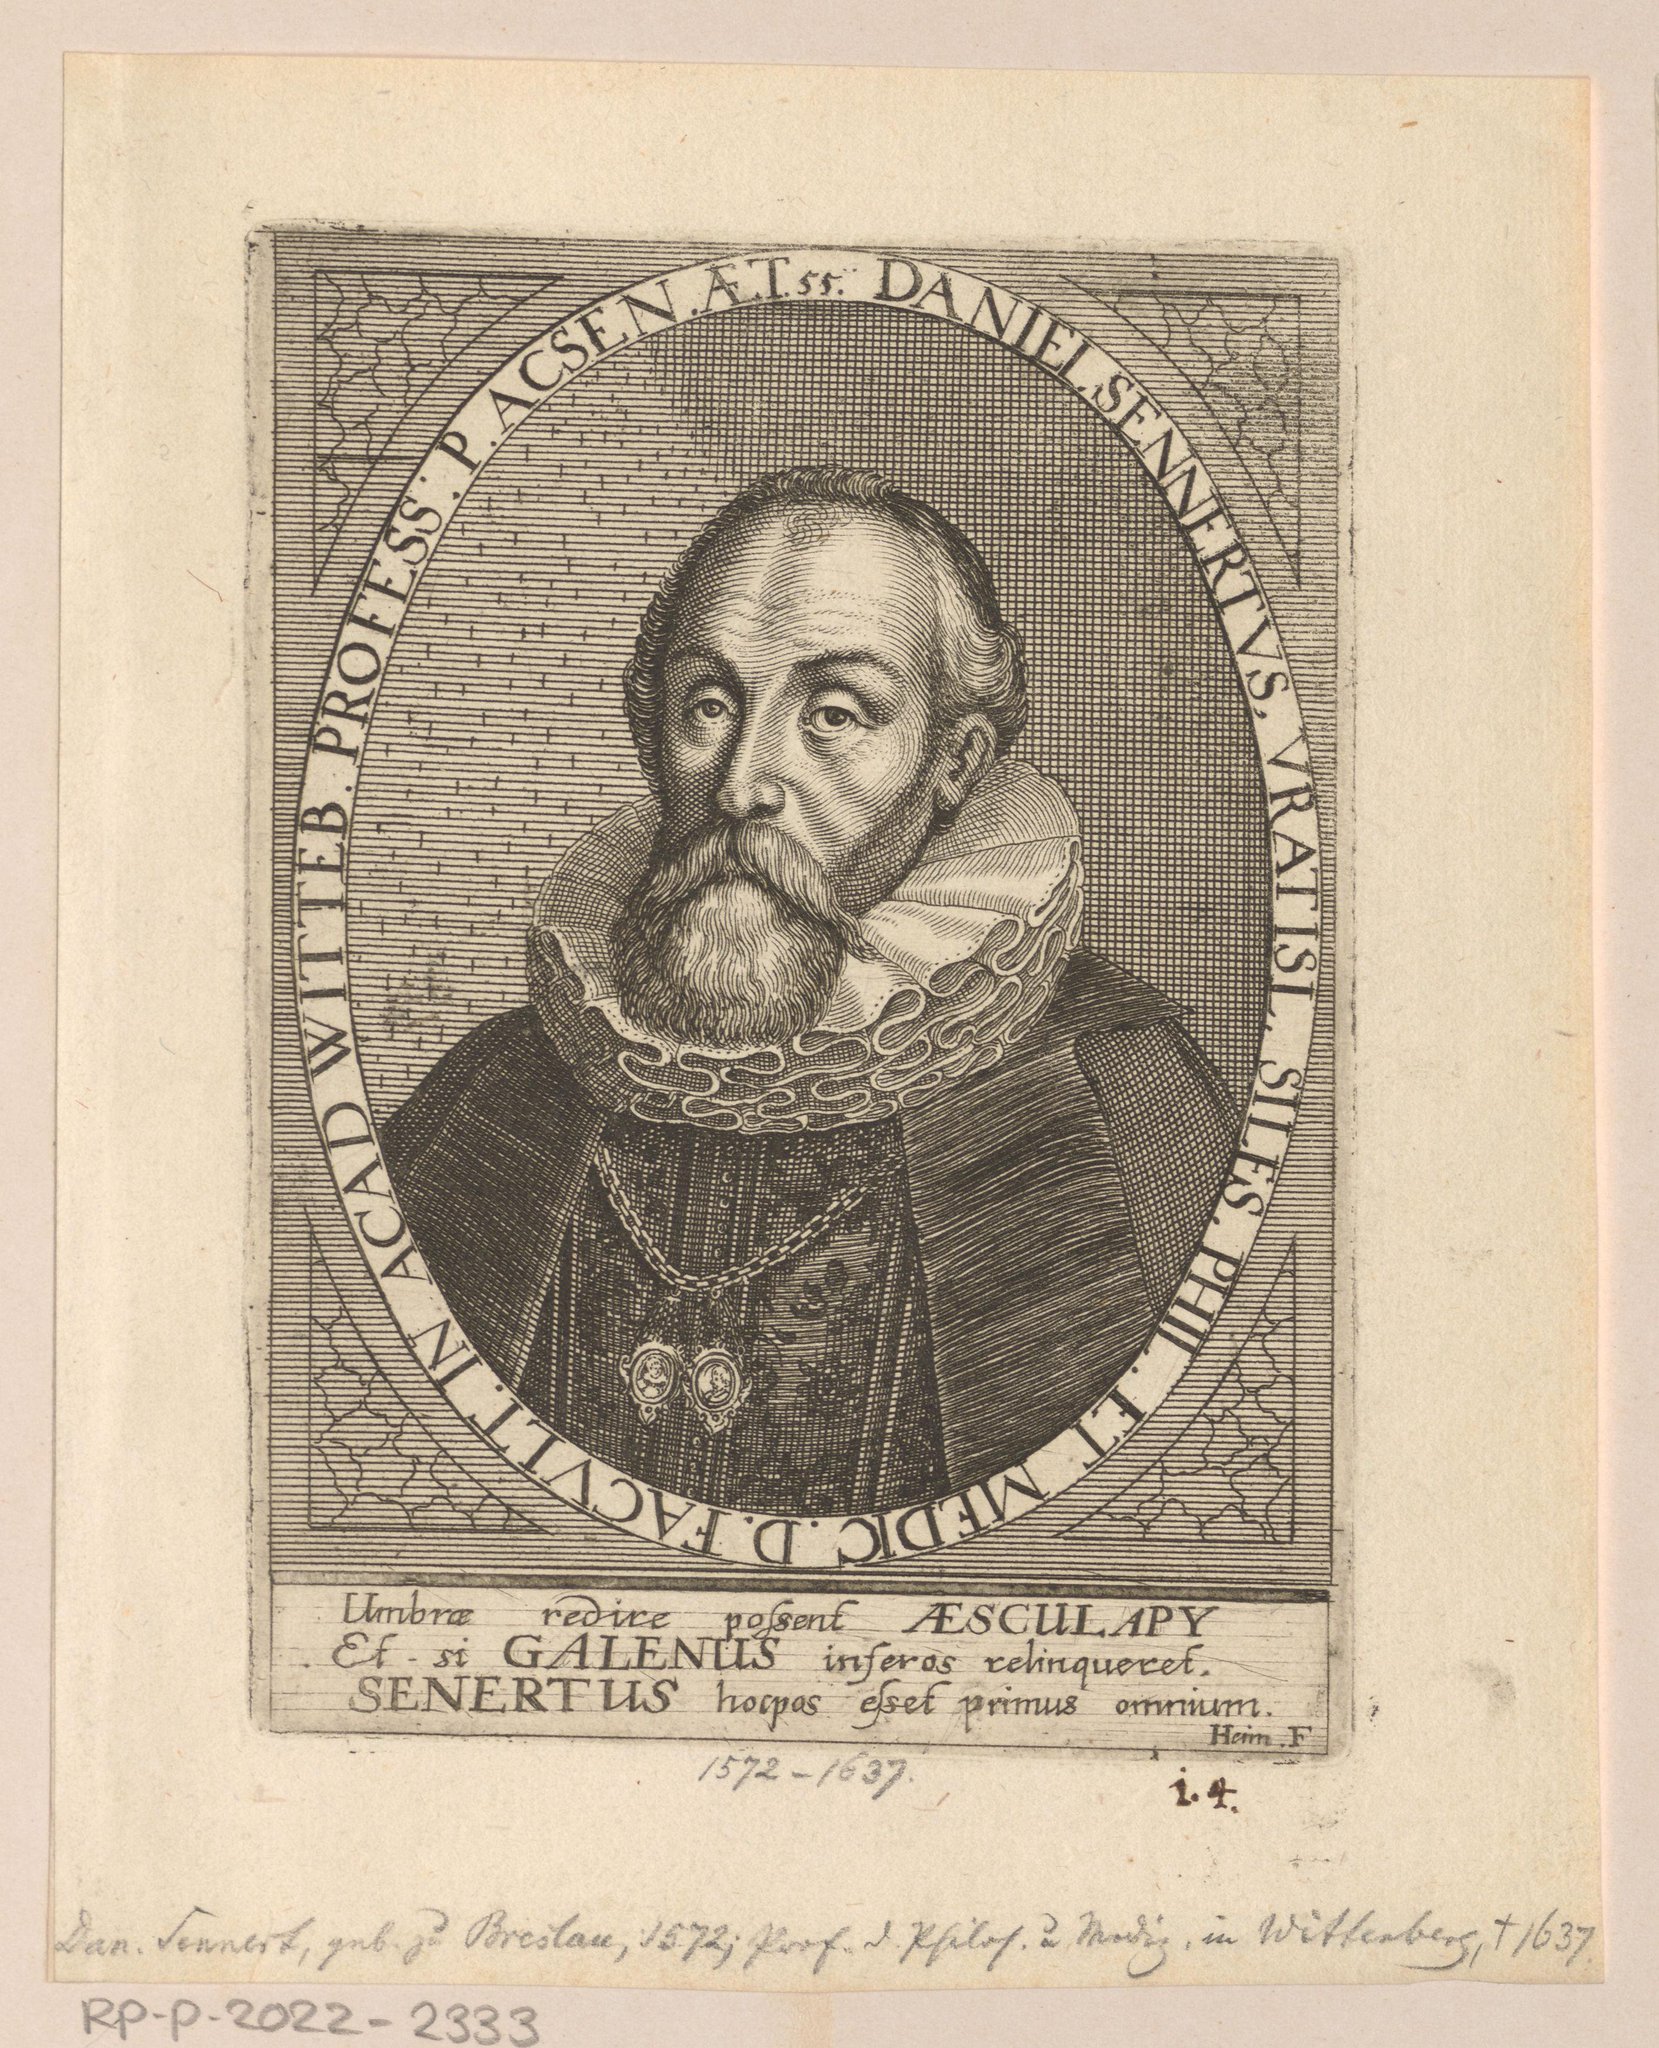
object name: print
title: Portret van Daniel Sennert op 55-jarige leeftijd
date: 1628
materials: paper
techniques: engraving, etching, intaglio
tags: scholar, philosopher, historical persons, physician, doctor, professor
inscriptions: inscription: ‘1572-1637 / Dan. Sennert geb. zu Breslau, 1572, Prof. u. [...] in Wittenberg, + 1637.’, number: ‘i.4.’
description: Latere staat van de prent gebruikt in: Boissard, Jean Jacques. Bibliotheca chalcographica hoc est virtute et eruditione clarorum virorum imagines Continuatio I. Heidelberg: Clemens Ammon, 1669, dl. 6.